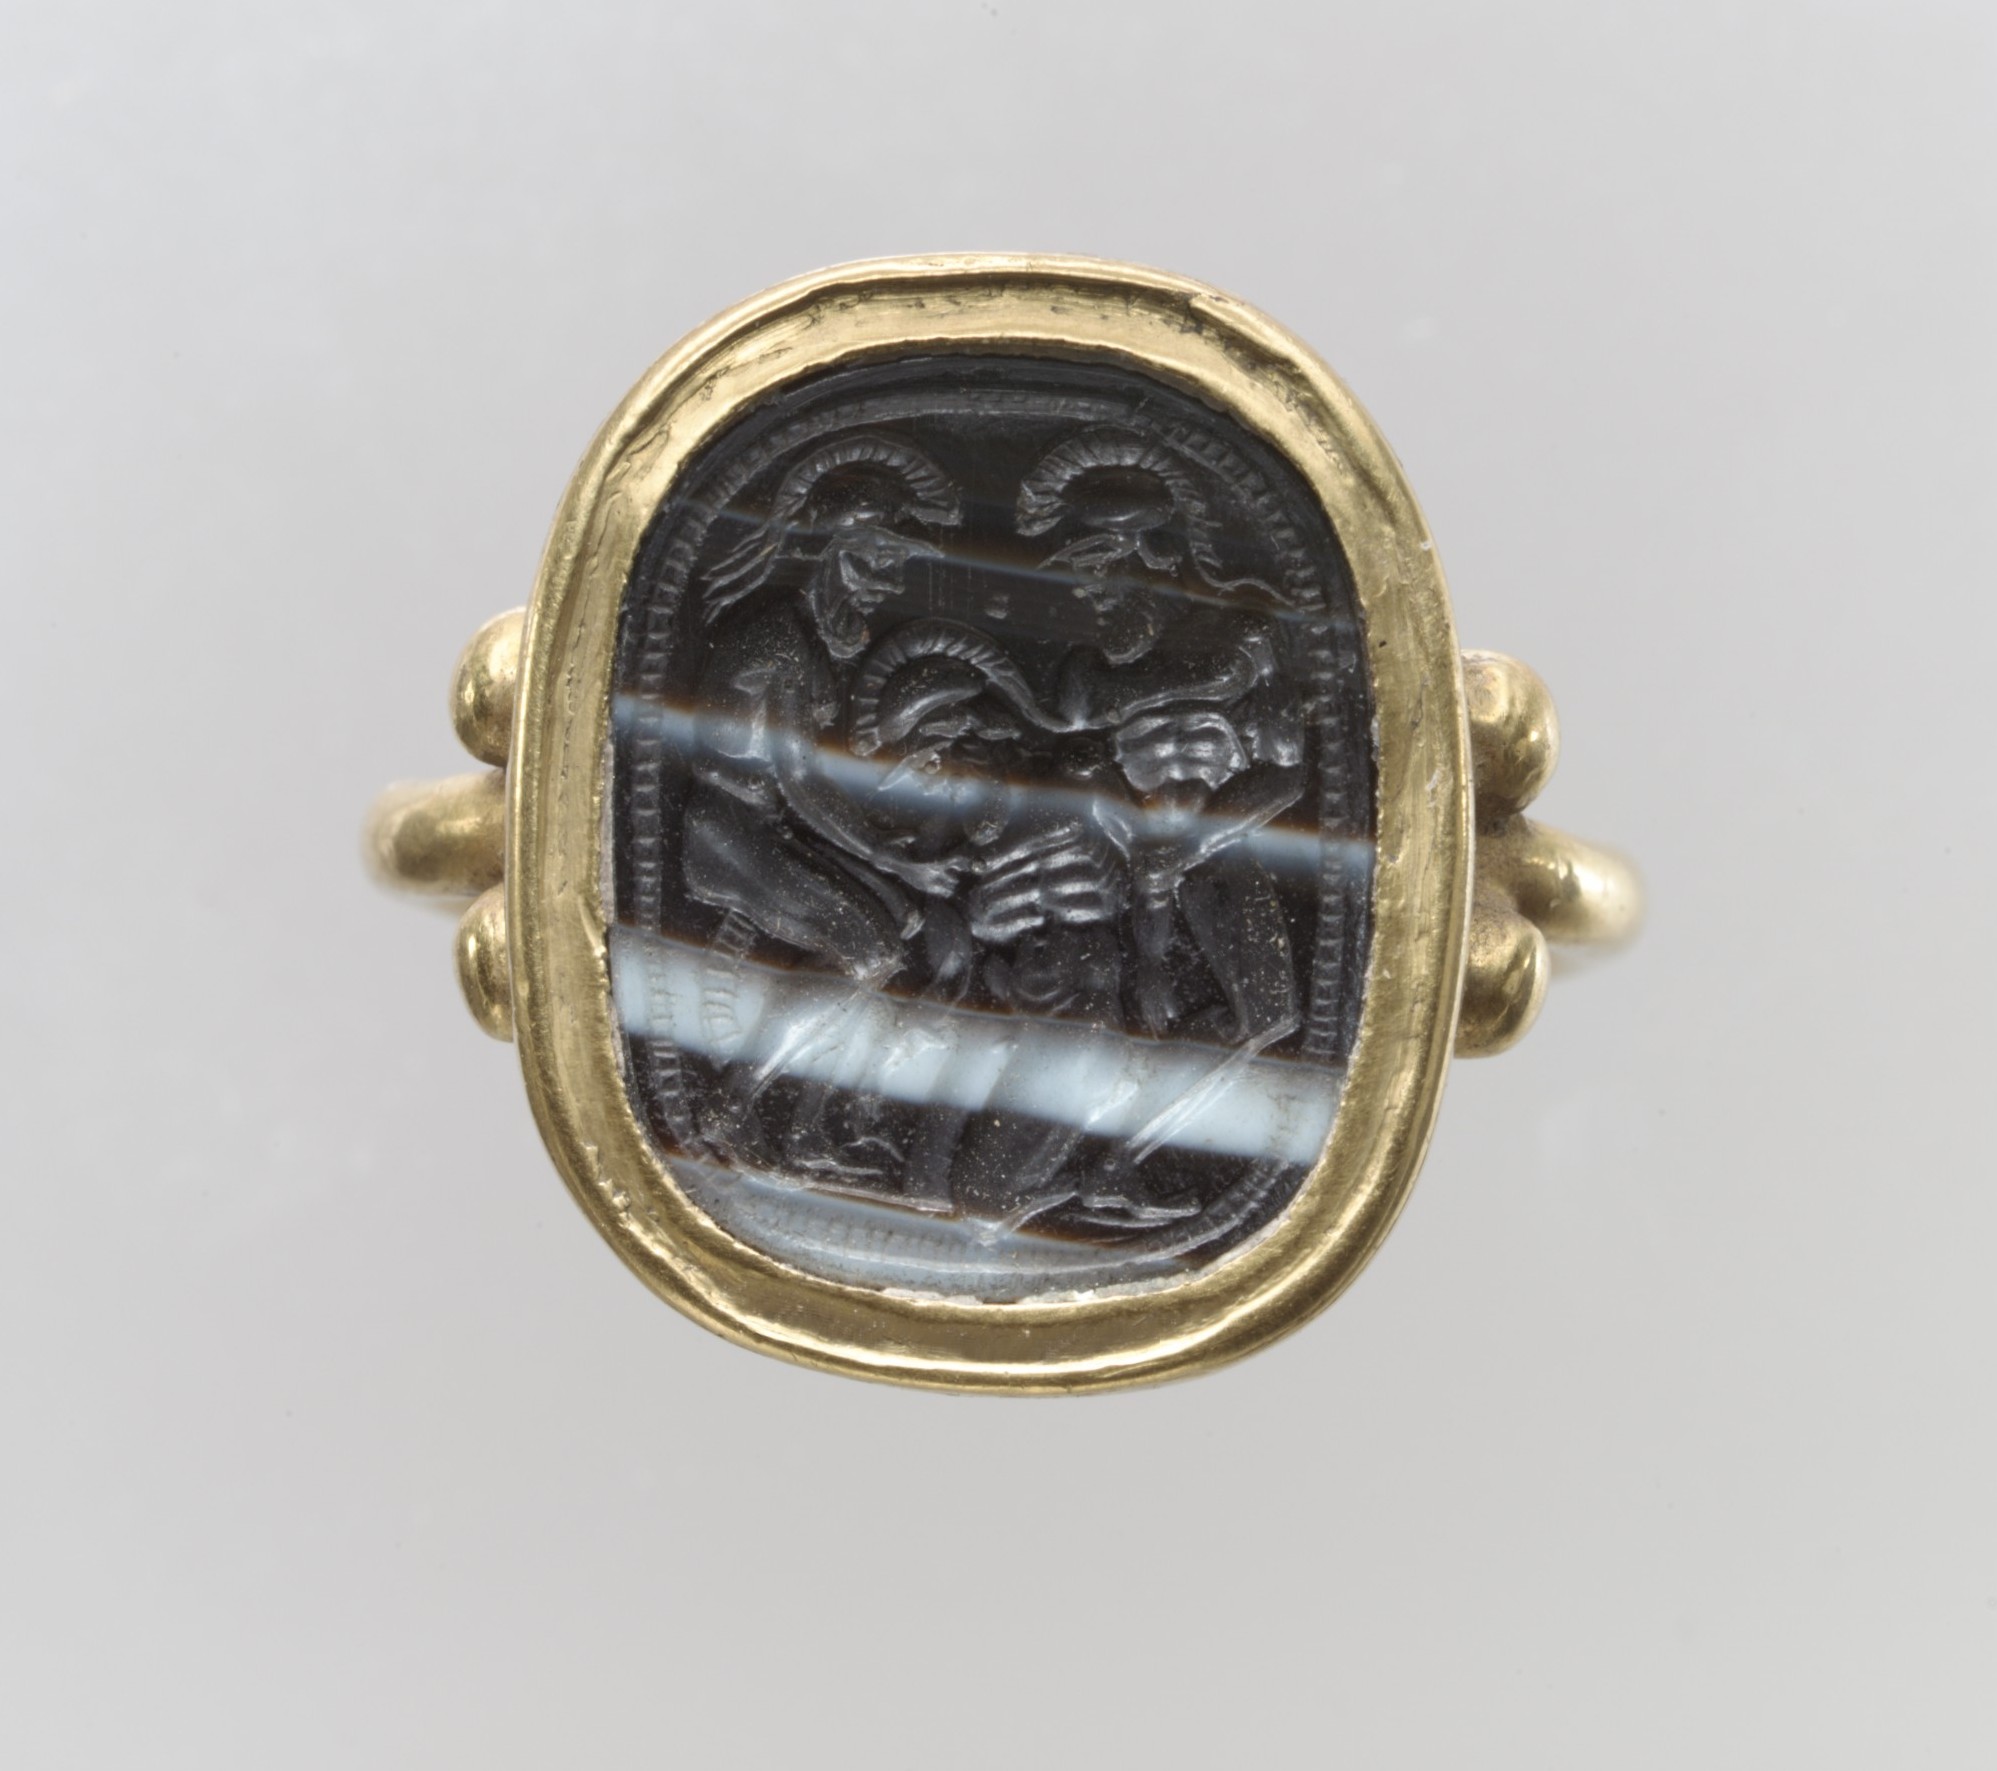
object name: intaglio in ring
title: Finger ring with ancient intaglio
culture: langobardic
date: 567-633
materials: stone, gold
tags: men,warriors